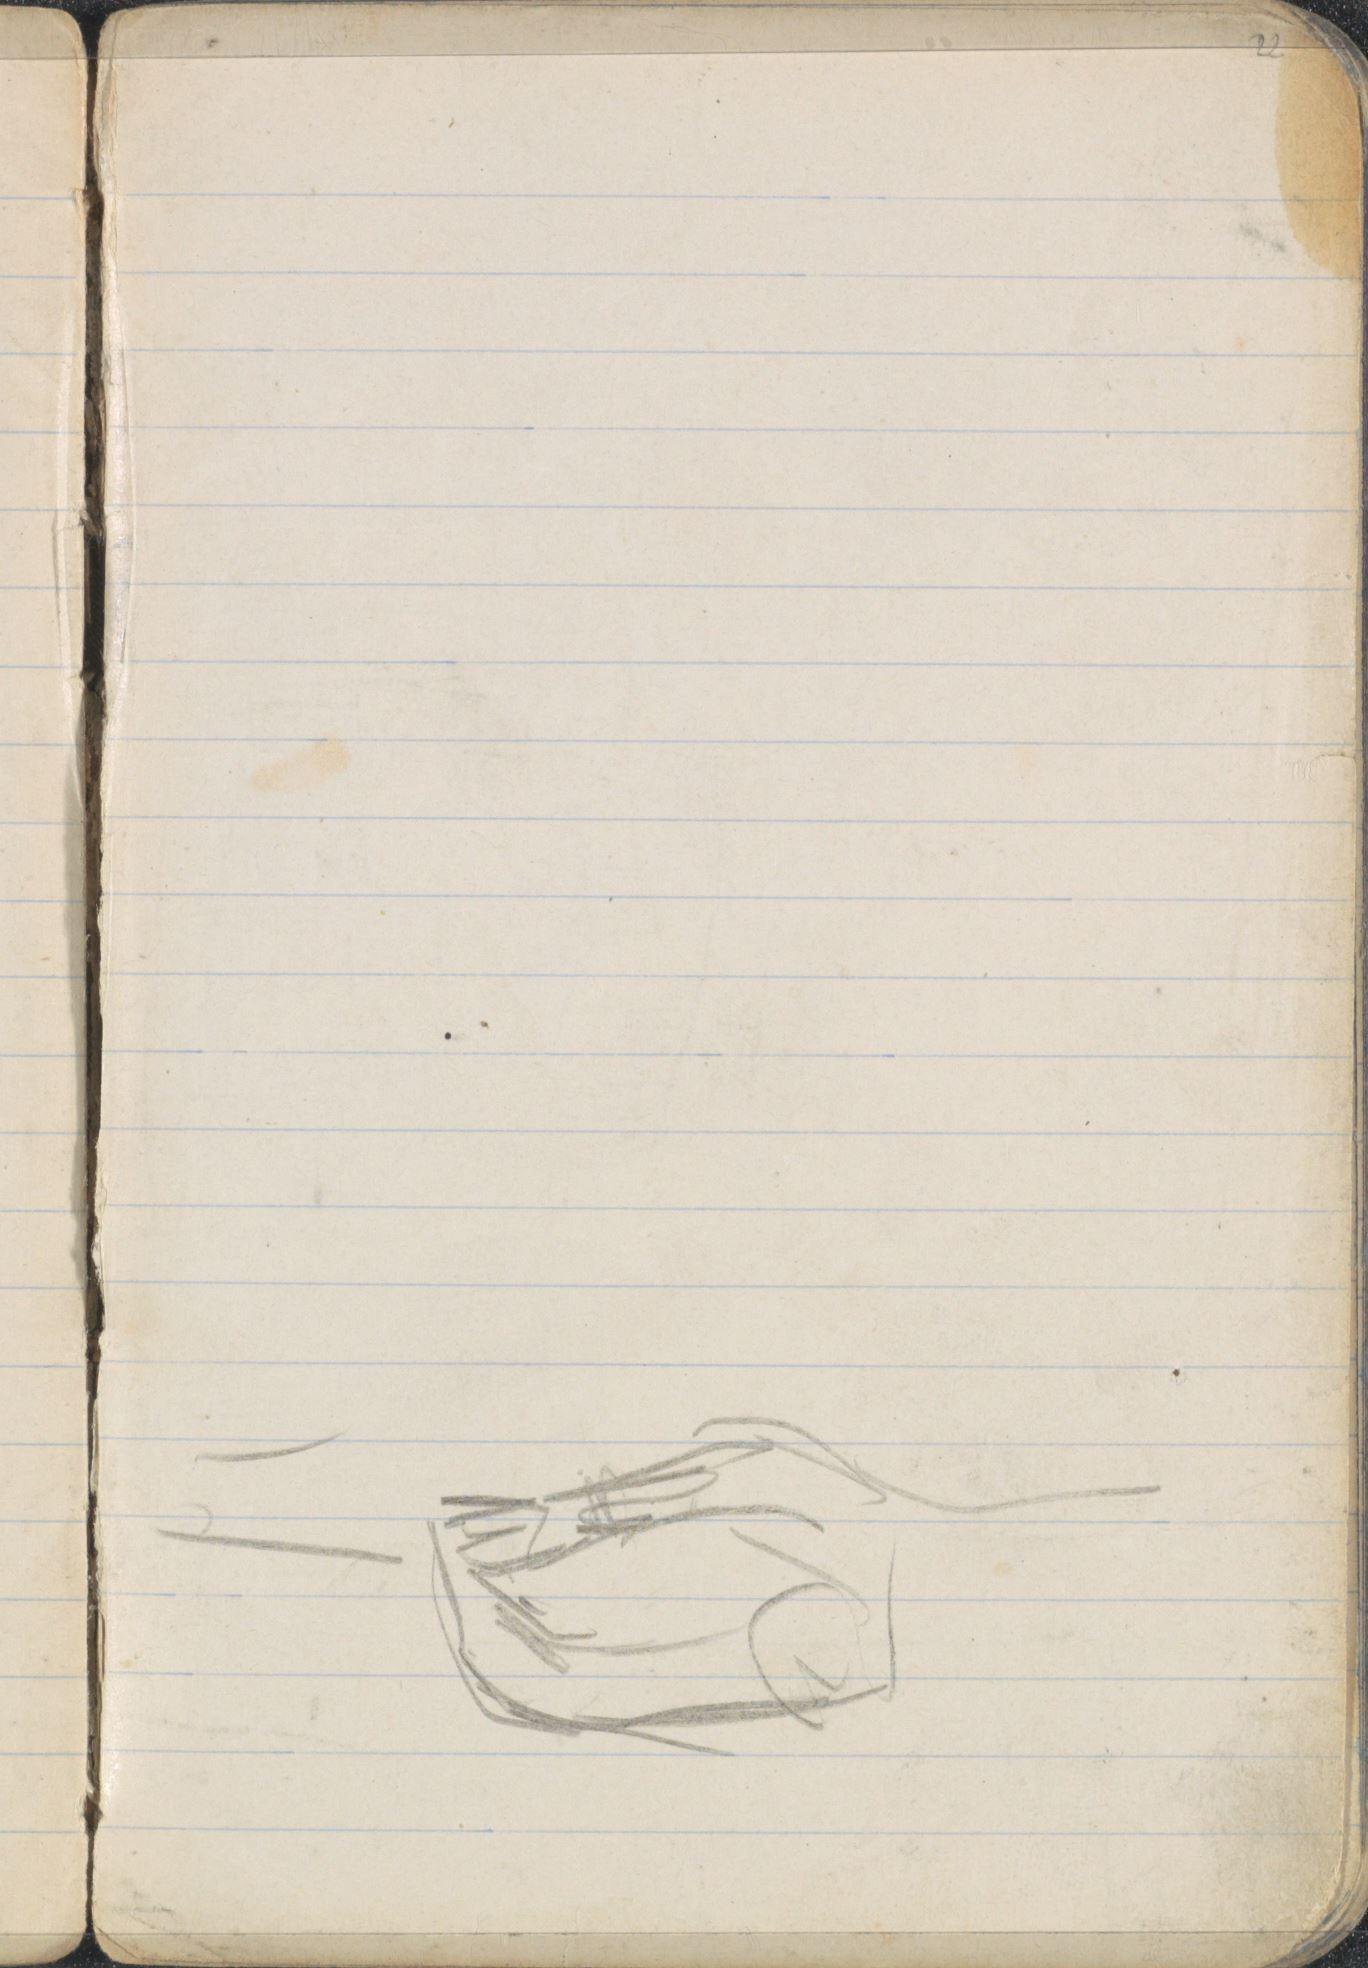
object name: sketchbook leaf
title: Studie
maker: george hendrik breitner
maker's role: draughtsman, painter, print maker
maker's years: 1857-1923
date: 1896-1897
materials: pencil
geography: amsterdam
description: Pagina 22 uit een schetsboek met 39 bladen.